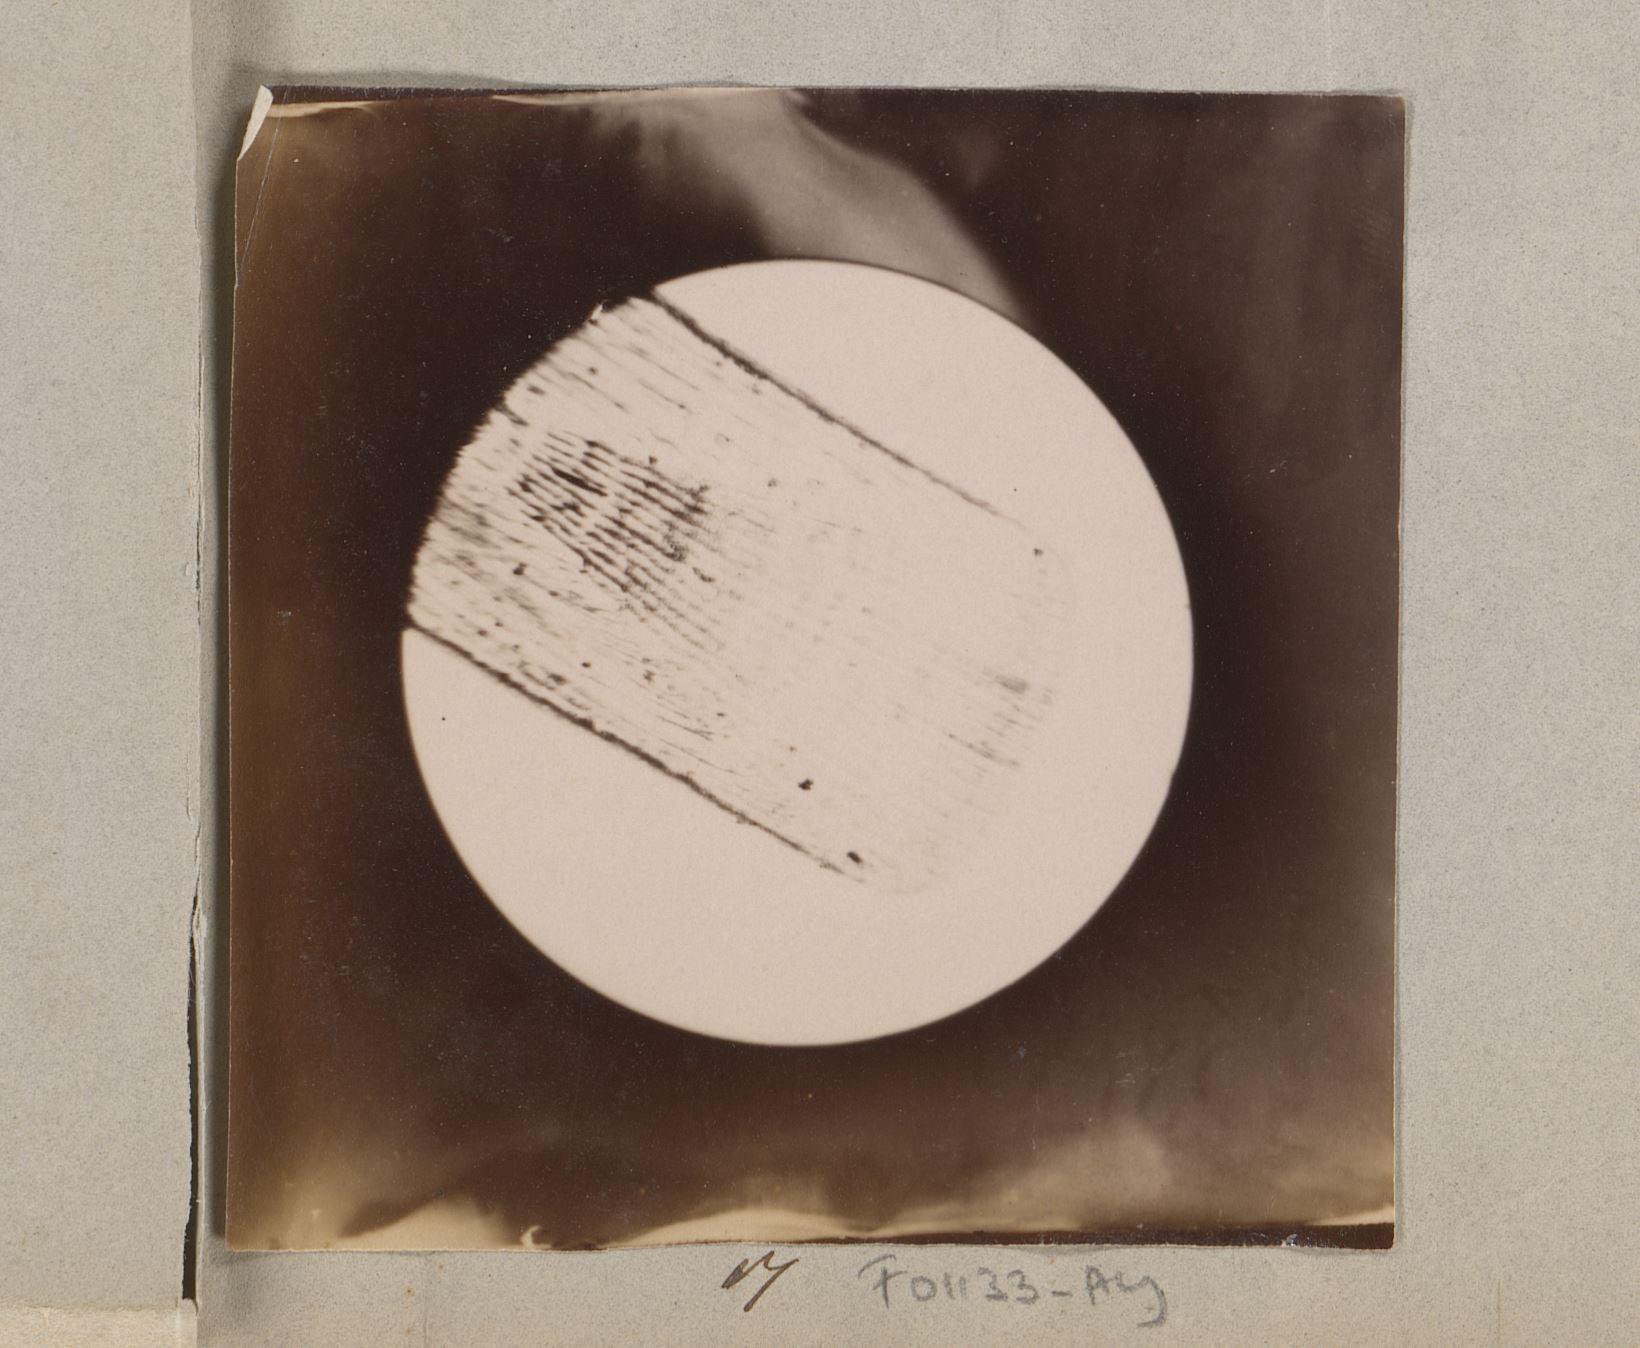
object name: album leaf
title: Microscopische opname van schub van een tong, 25 keer vergroot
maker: marinus pieter filbri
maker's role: instrument maker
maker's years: 1852-1917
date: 1887-1888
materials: paper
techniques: albumen print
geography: netherlands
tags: fishes, netherlands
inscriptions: inscription: ‘No. 17. Benaming Schub van eene tong (boven), 25 x vergroot, pose 4 min., bemerking id.’, number: ‘17’